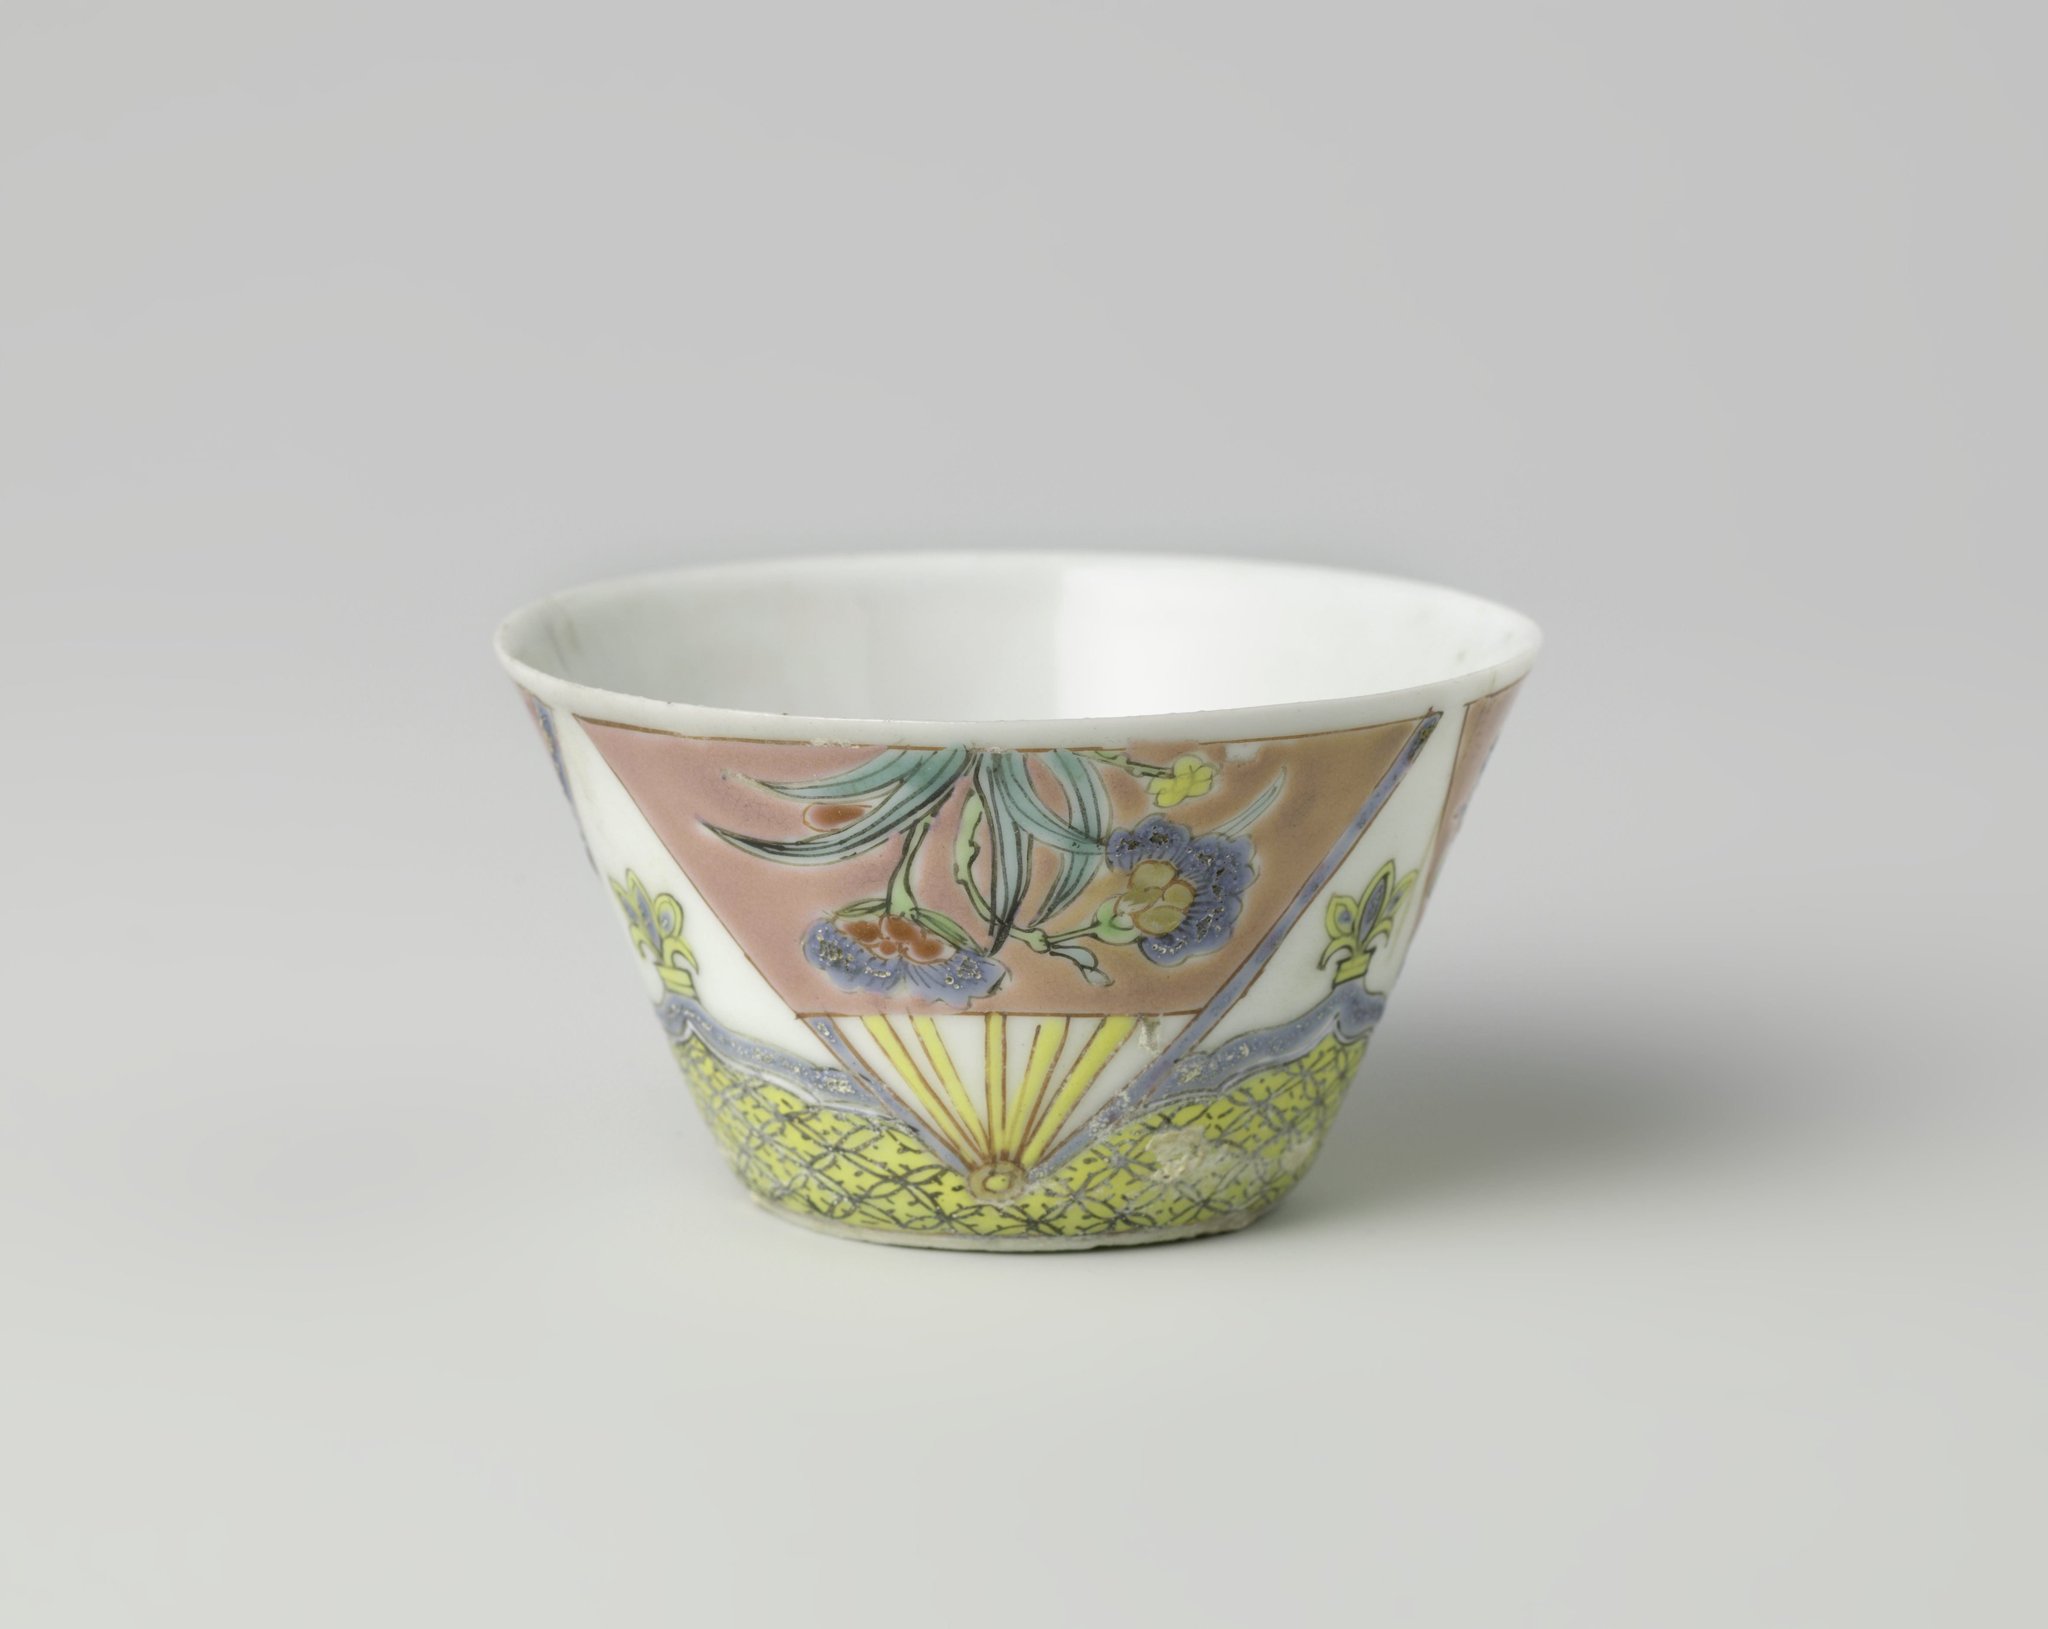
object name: cup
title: Cup with cock and three fans with flower sprays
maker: Anonymous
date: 1725-1749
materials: glaze, gold, paint, porcelain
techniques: firing, gilding, turning, vitrification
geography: china